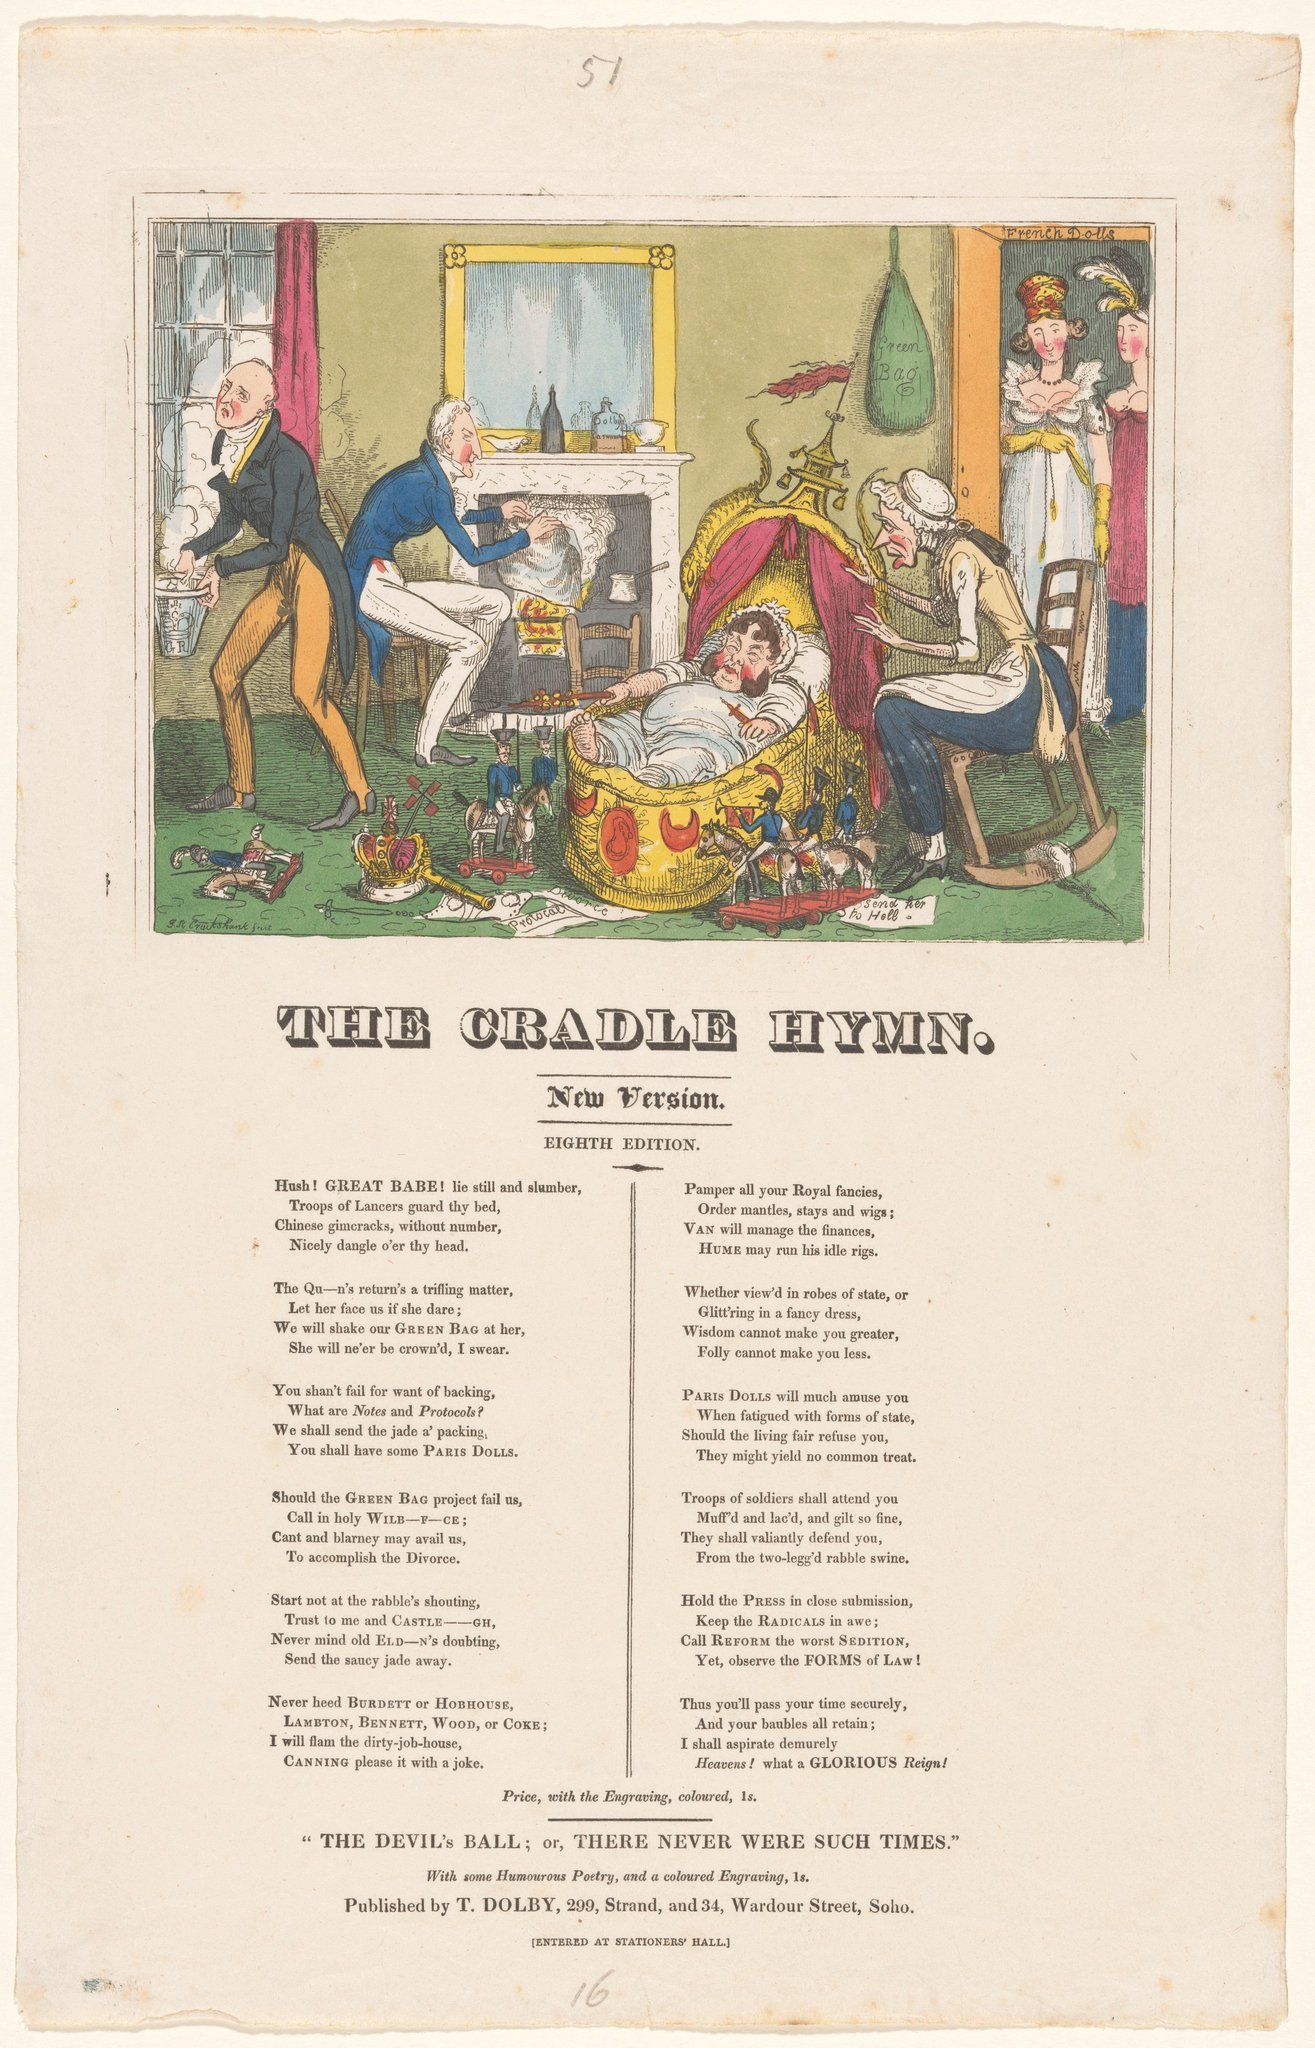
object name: cartoon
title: The cradle hymn. New version. Eight edition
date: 1820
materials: paper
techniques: etching, hand coloring, letterpress printing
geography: london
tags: george iv (koning van het verenigd koninkrijk), cradle, crib, political caricatures and satires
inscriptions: collector's mark: Lugt 2760, collector's mark: Lugt 2228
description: Spotprent op koning George IV, 1820. De koning voorgesteld als een groot kind in een wieg, verzorgd en gewiegd. Onder de plaat een lied in twaalf coupletten.